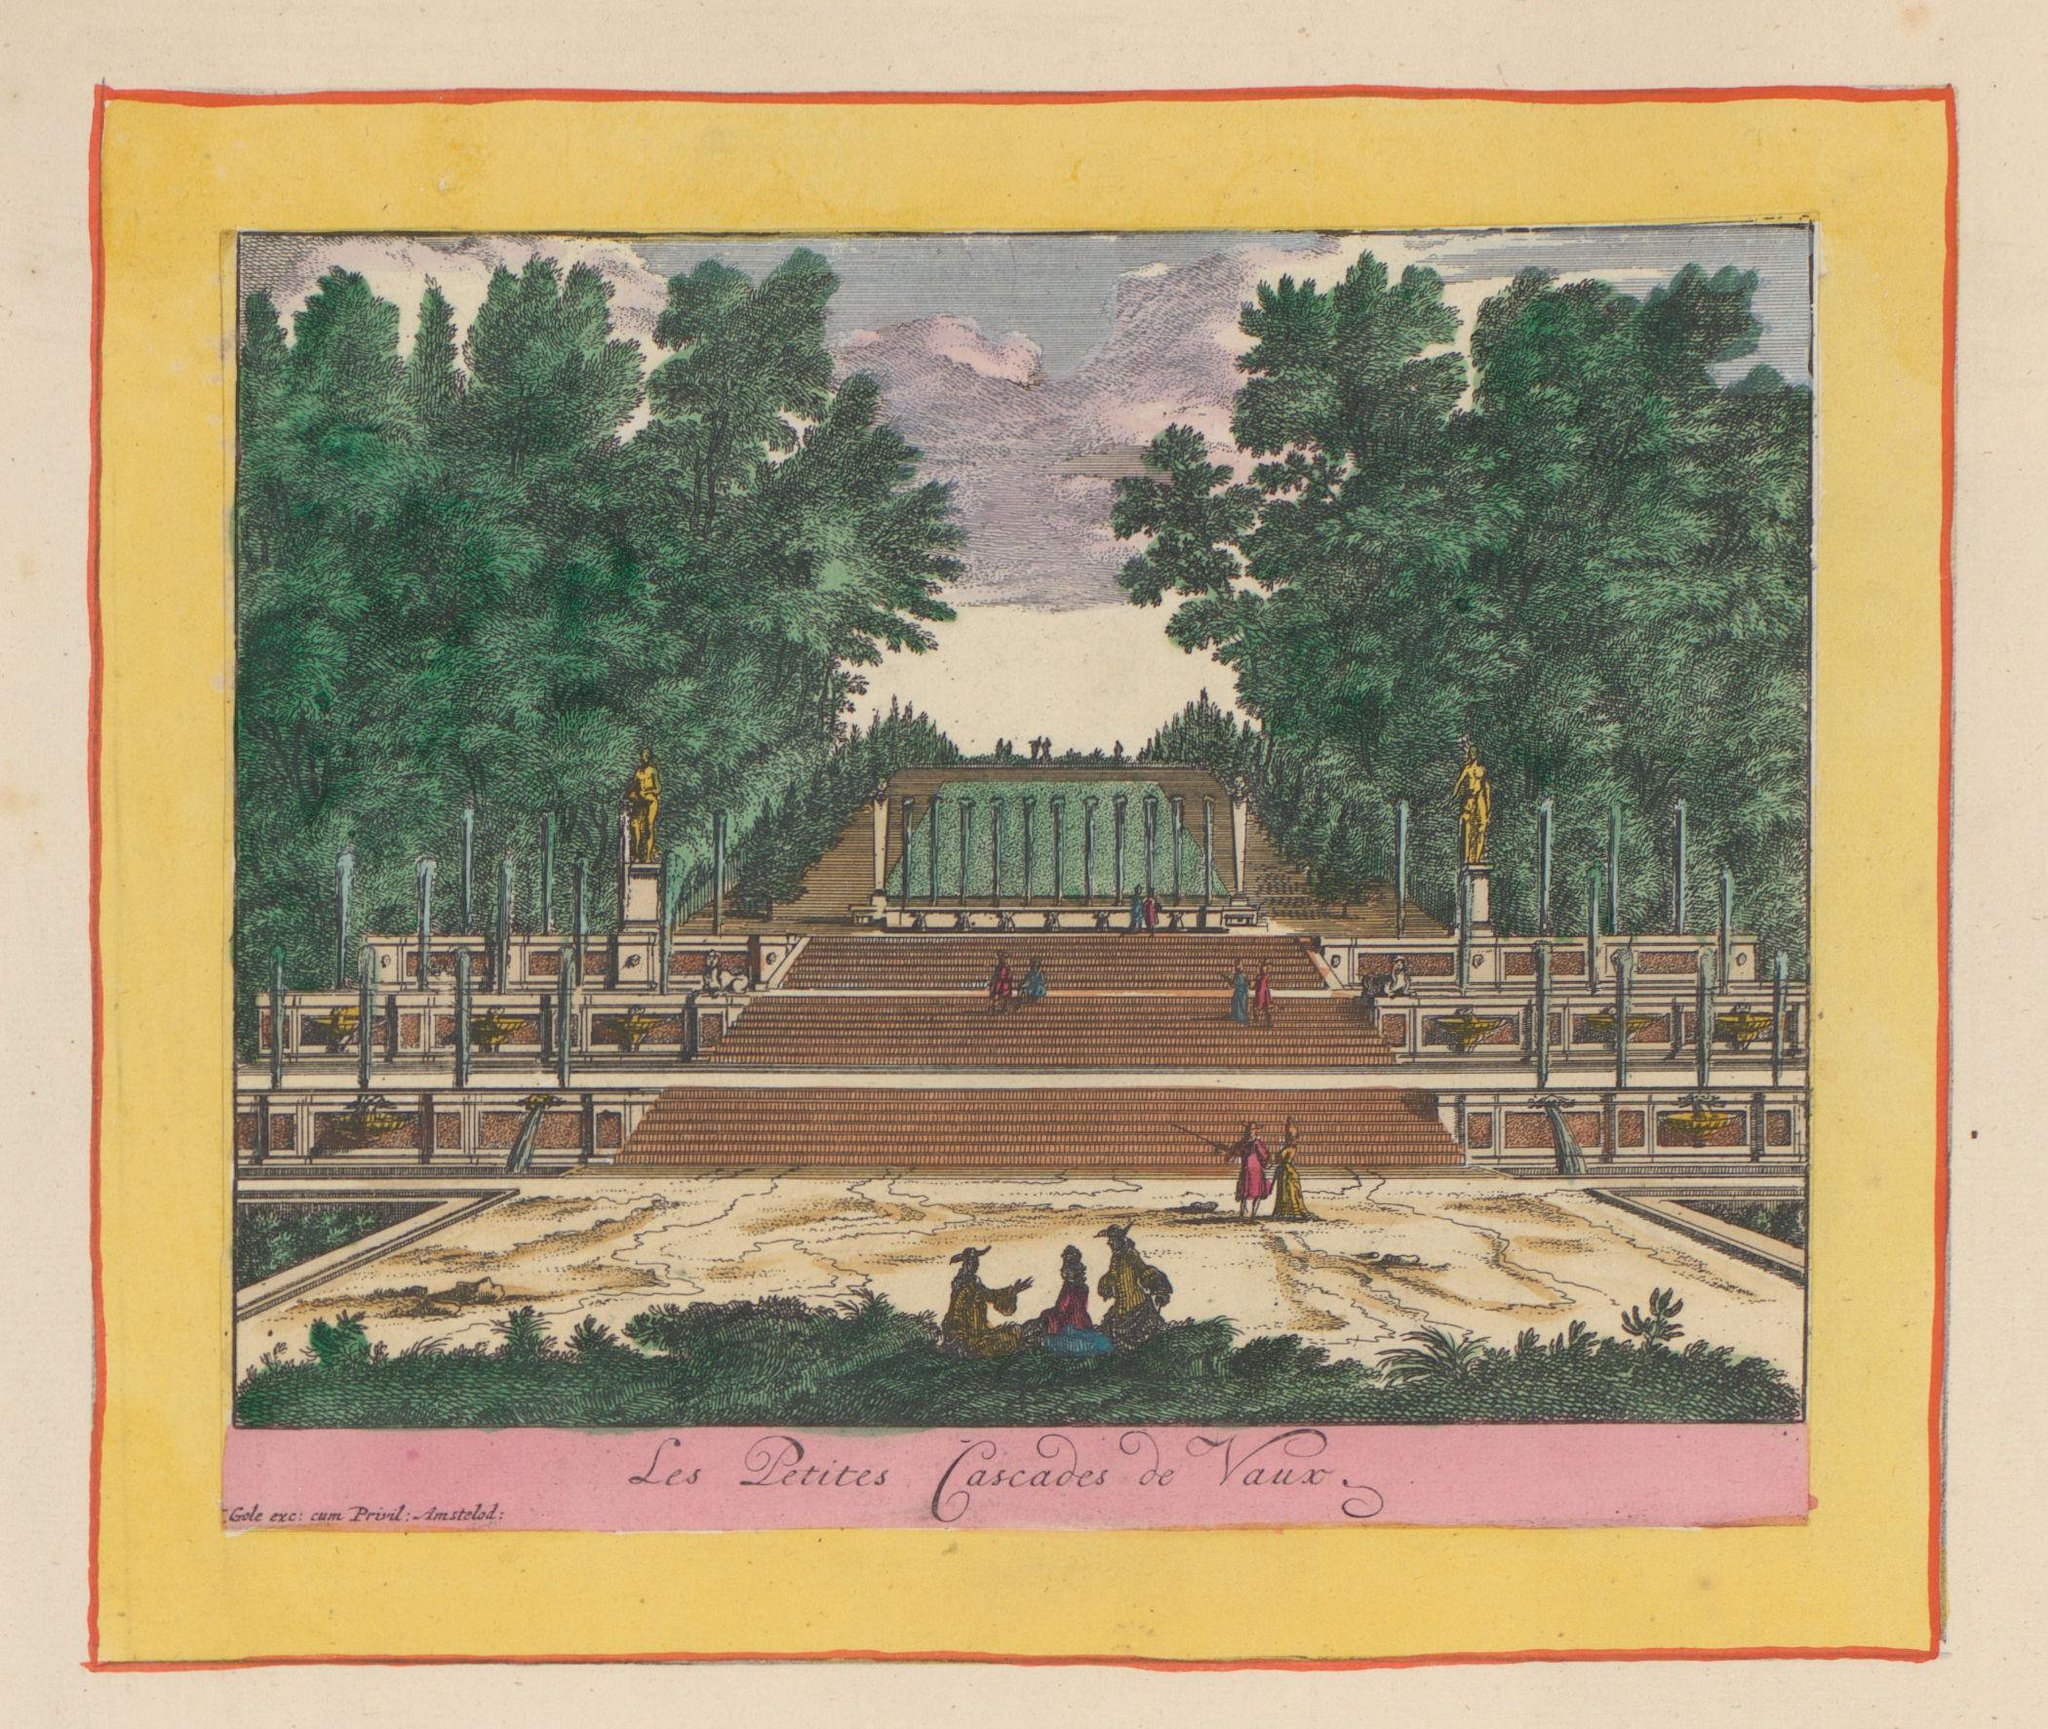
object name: print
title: Gezichten op Château de Vaux-le-Vicomte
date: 1681-1724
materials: paper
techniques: etching, hand coloring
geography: the hague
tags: french or architectonic garden; formal garden, garden cascade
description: Gezicht op de kleine cascades in de tuinen van Château de Vaux-le-Vicomte. In het midden trappen. Prent maakt deel uit van een album.